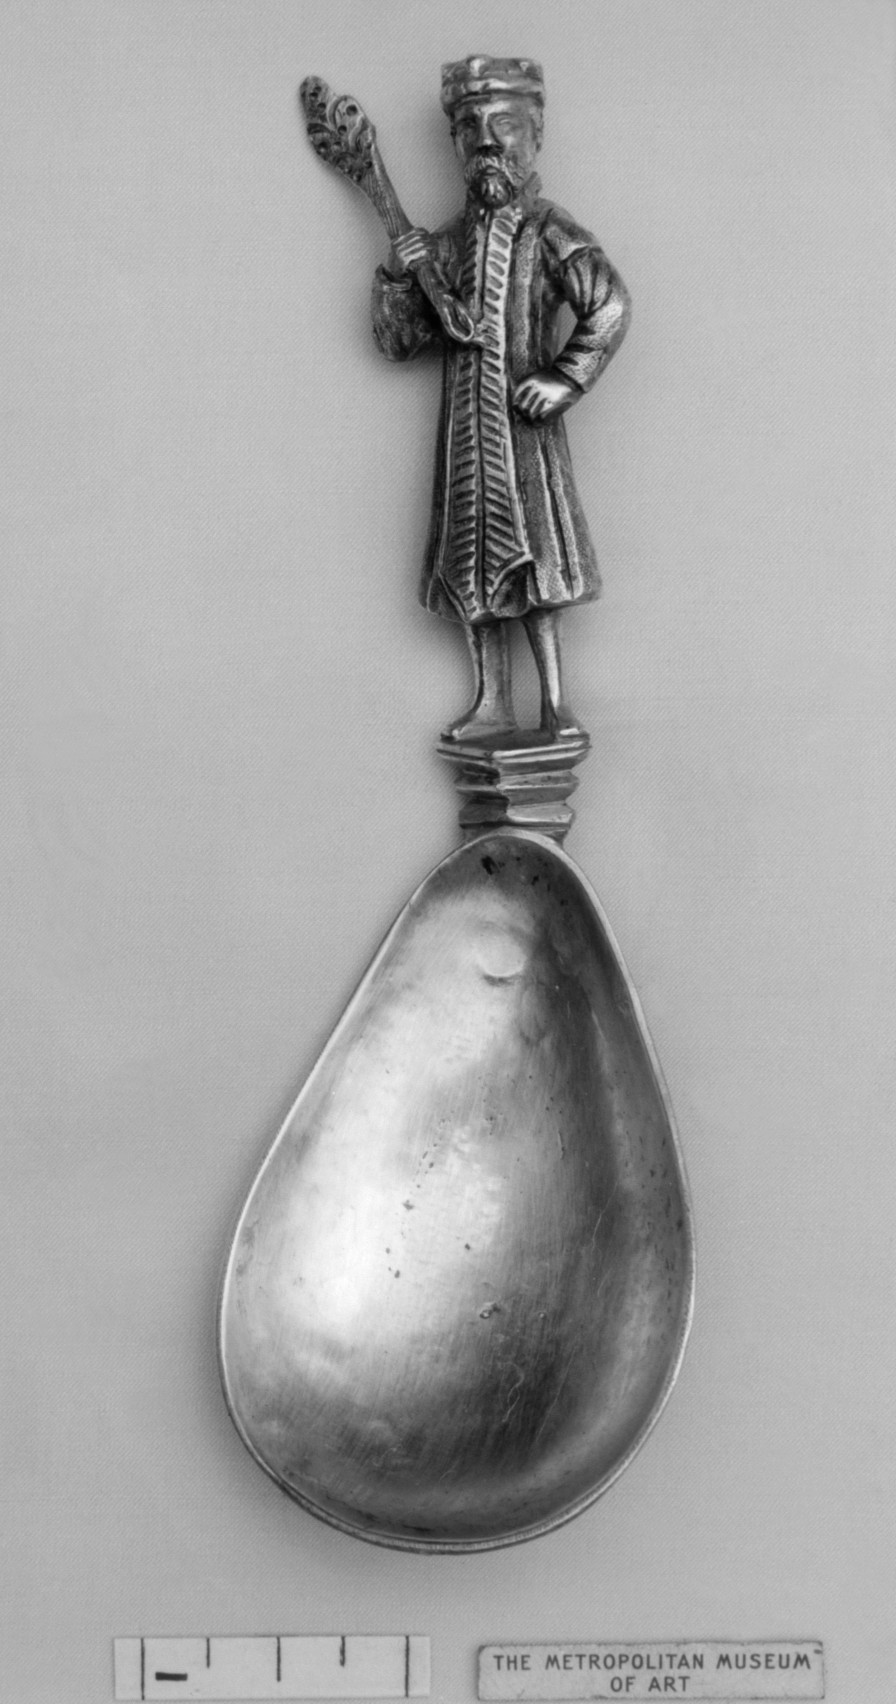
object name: spoon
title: Figure-top spoon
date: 1551-1600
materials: gilt, silver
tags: men